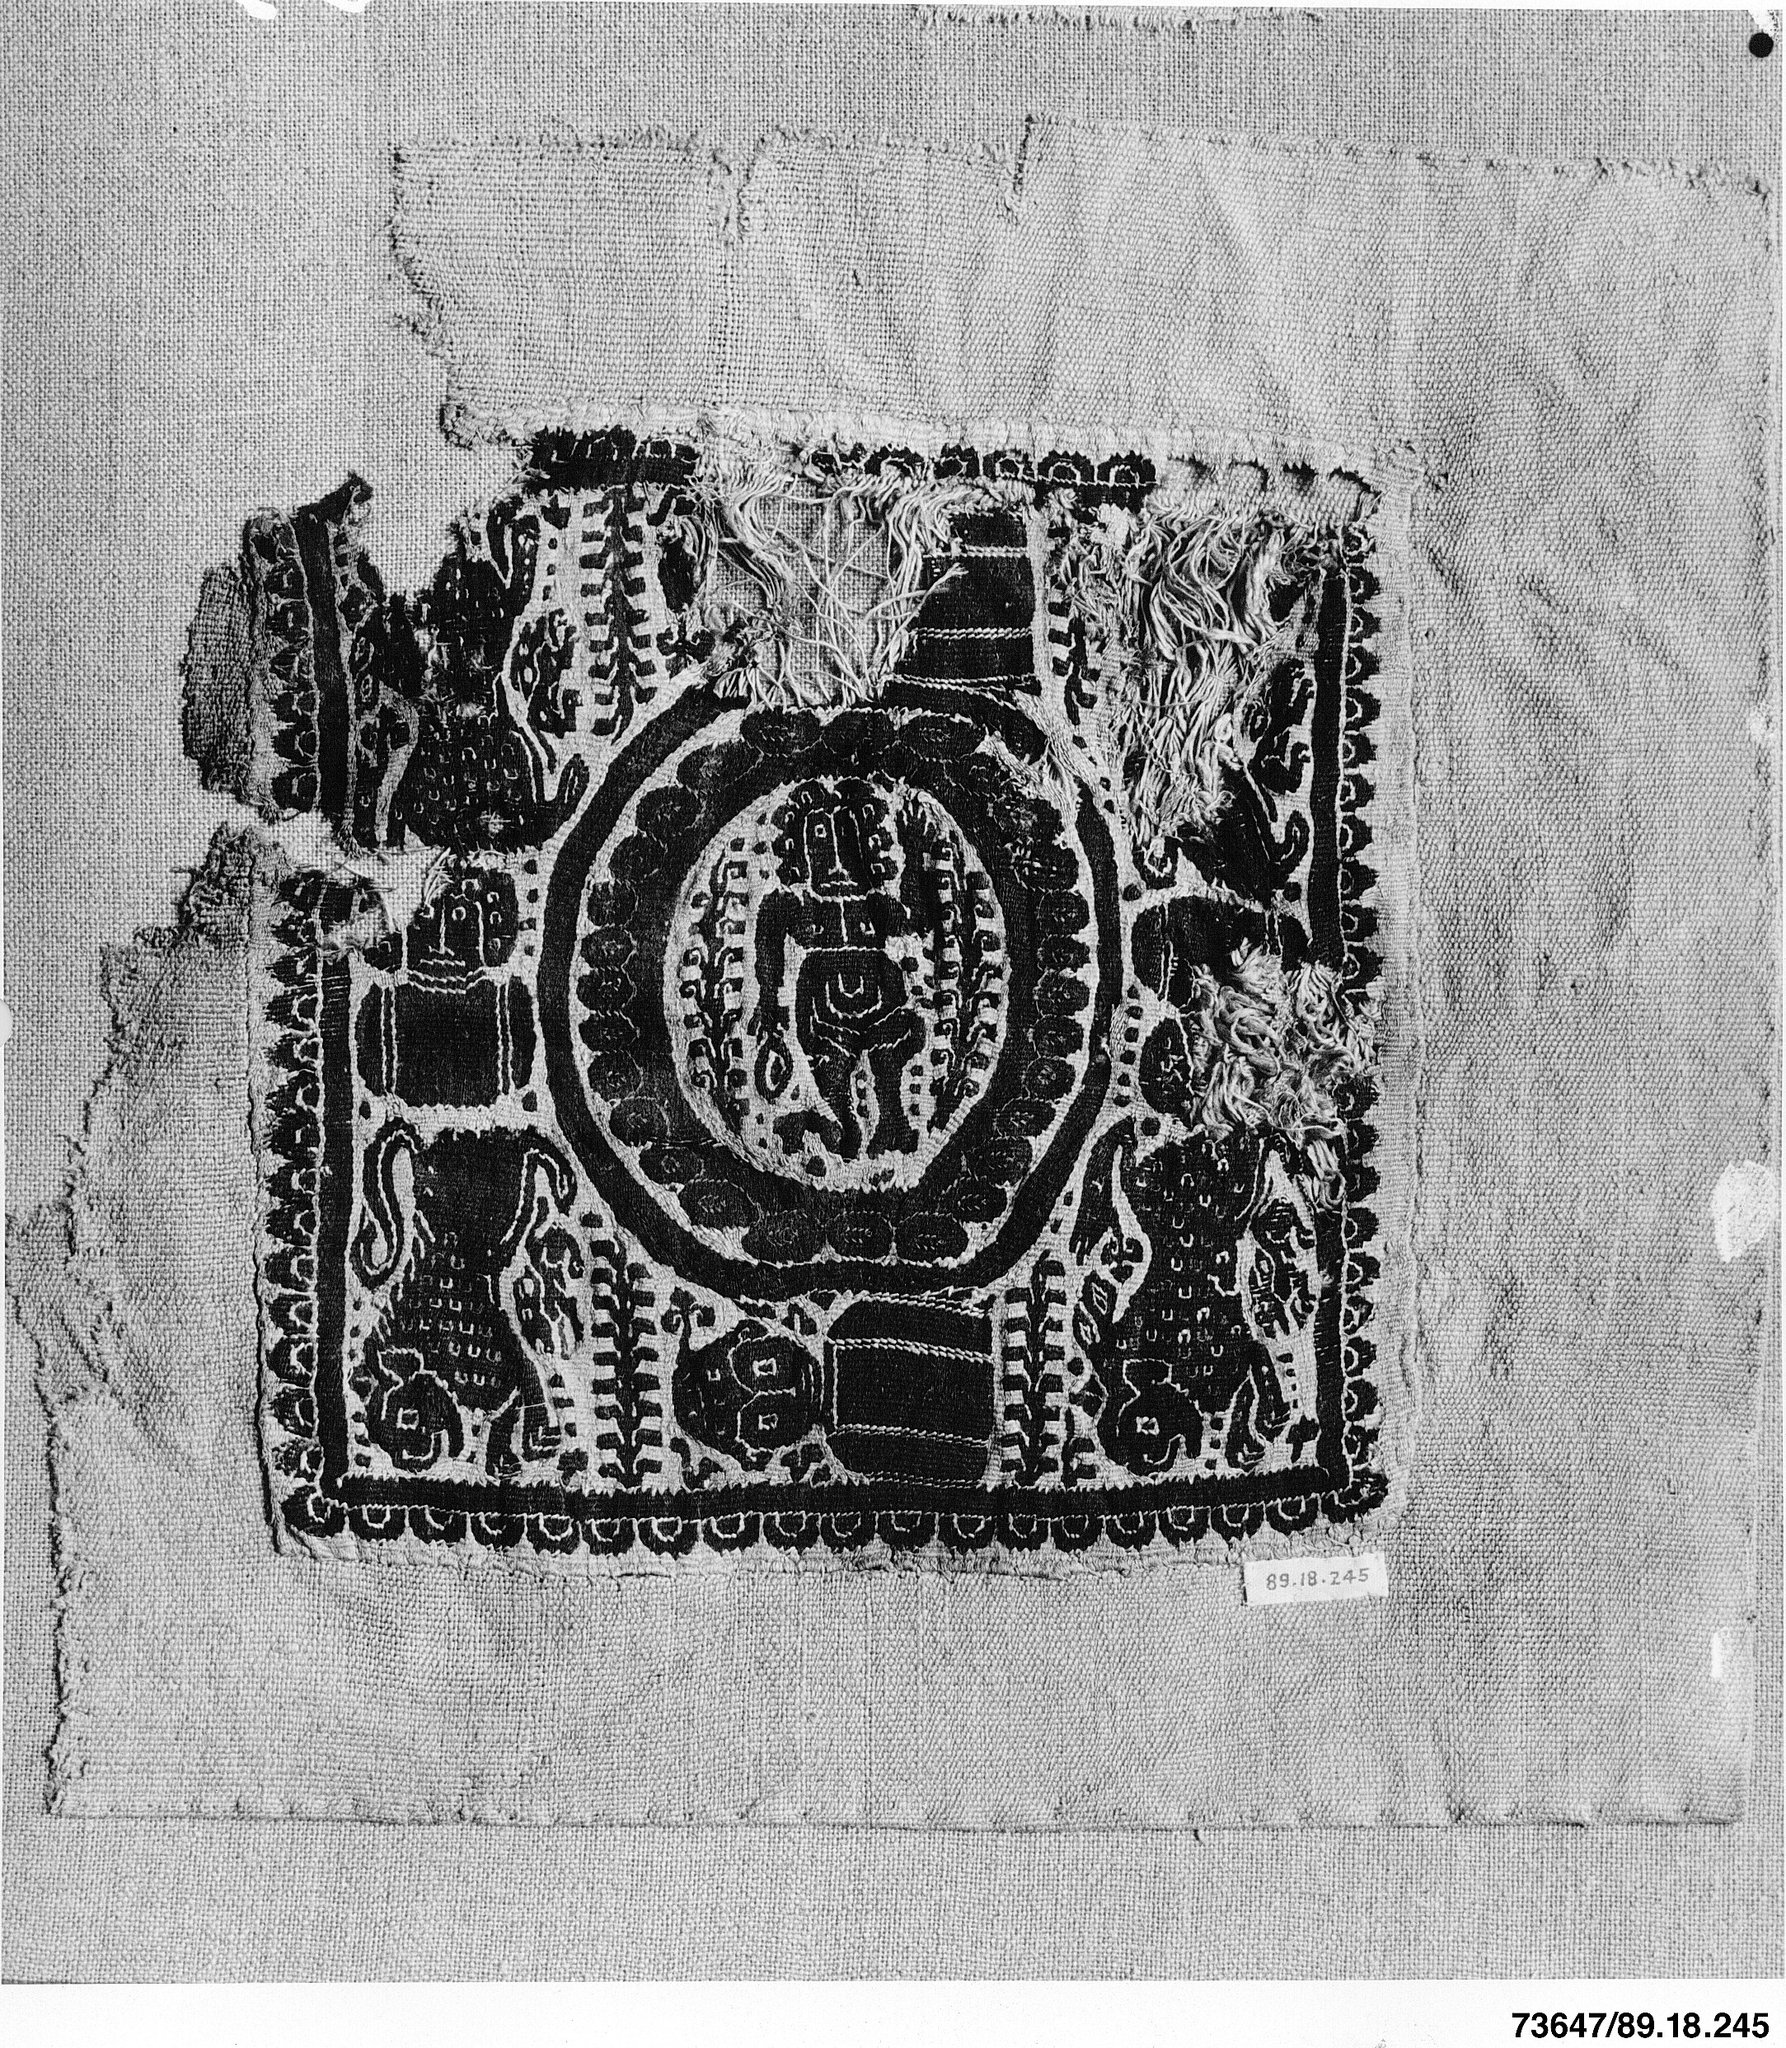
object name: textile fragment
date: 301-400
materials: linen, wool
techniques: weave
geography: egypt